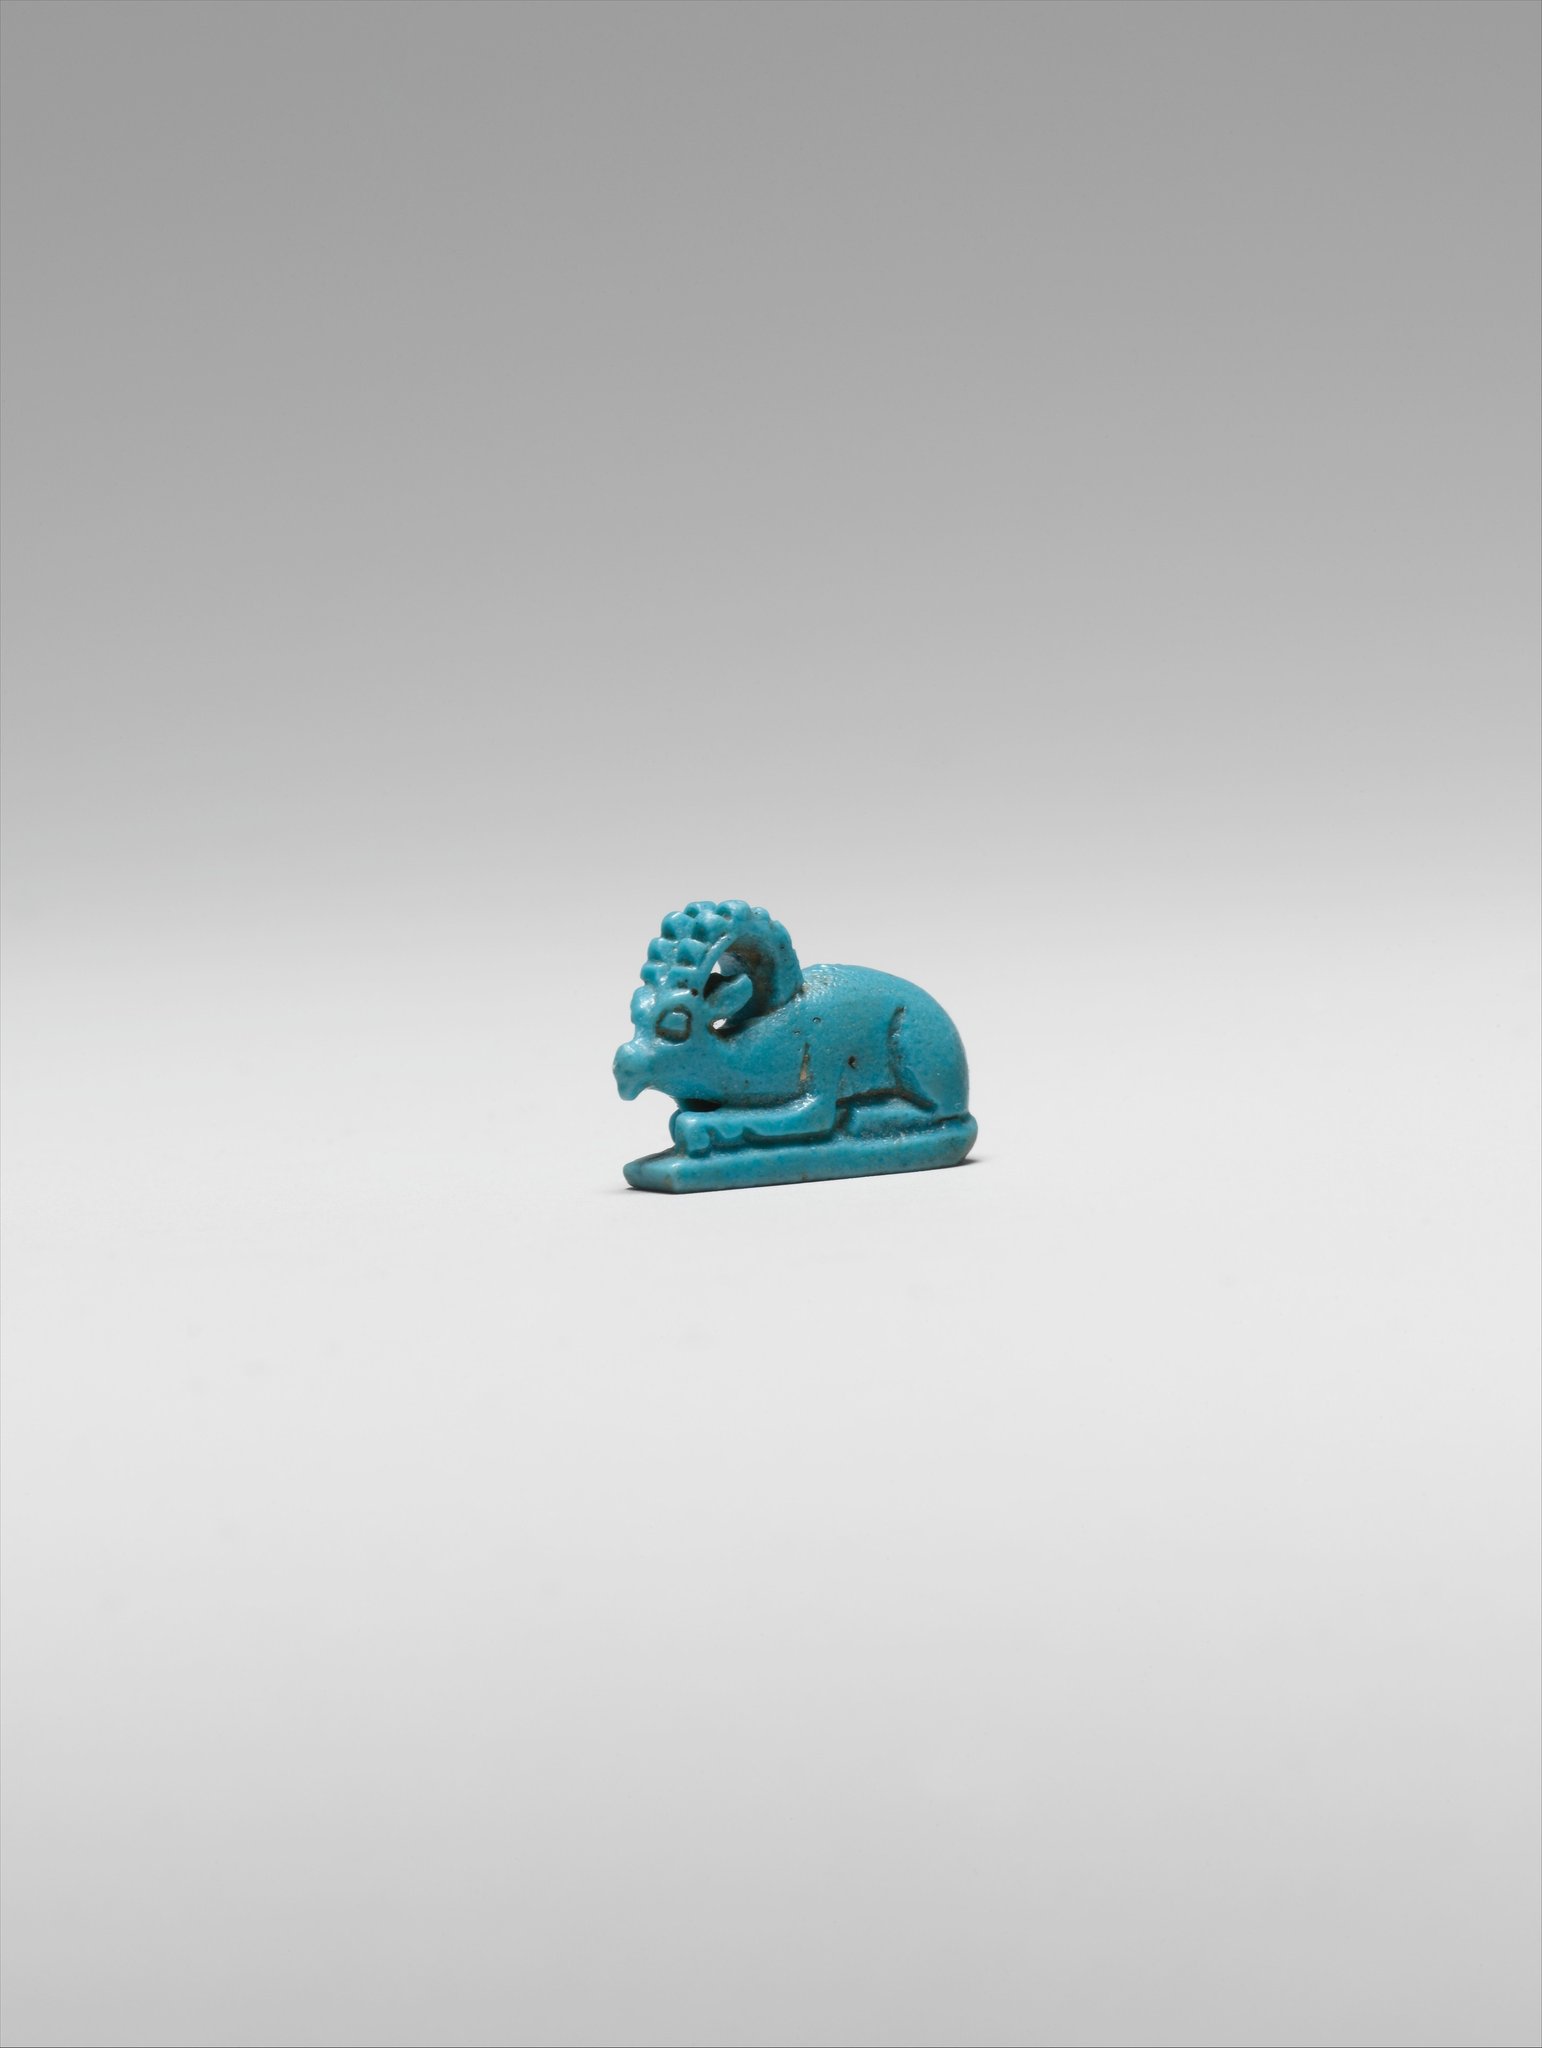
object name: stamp seal, ibex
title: Ibex-Shaped Design Amulet Inscribed With A Crocodile and A Fish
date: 1550-1295 BCE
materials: faience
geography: egypt